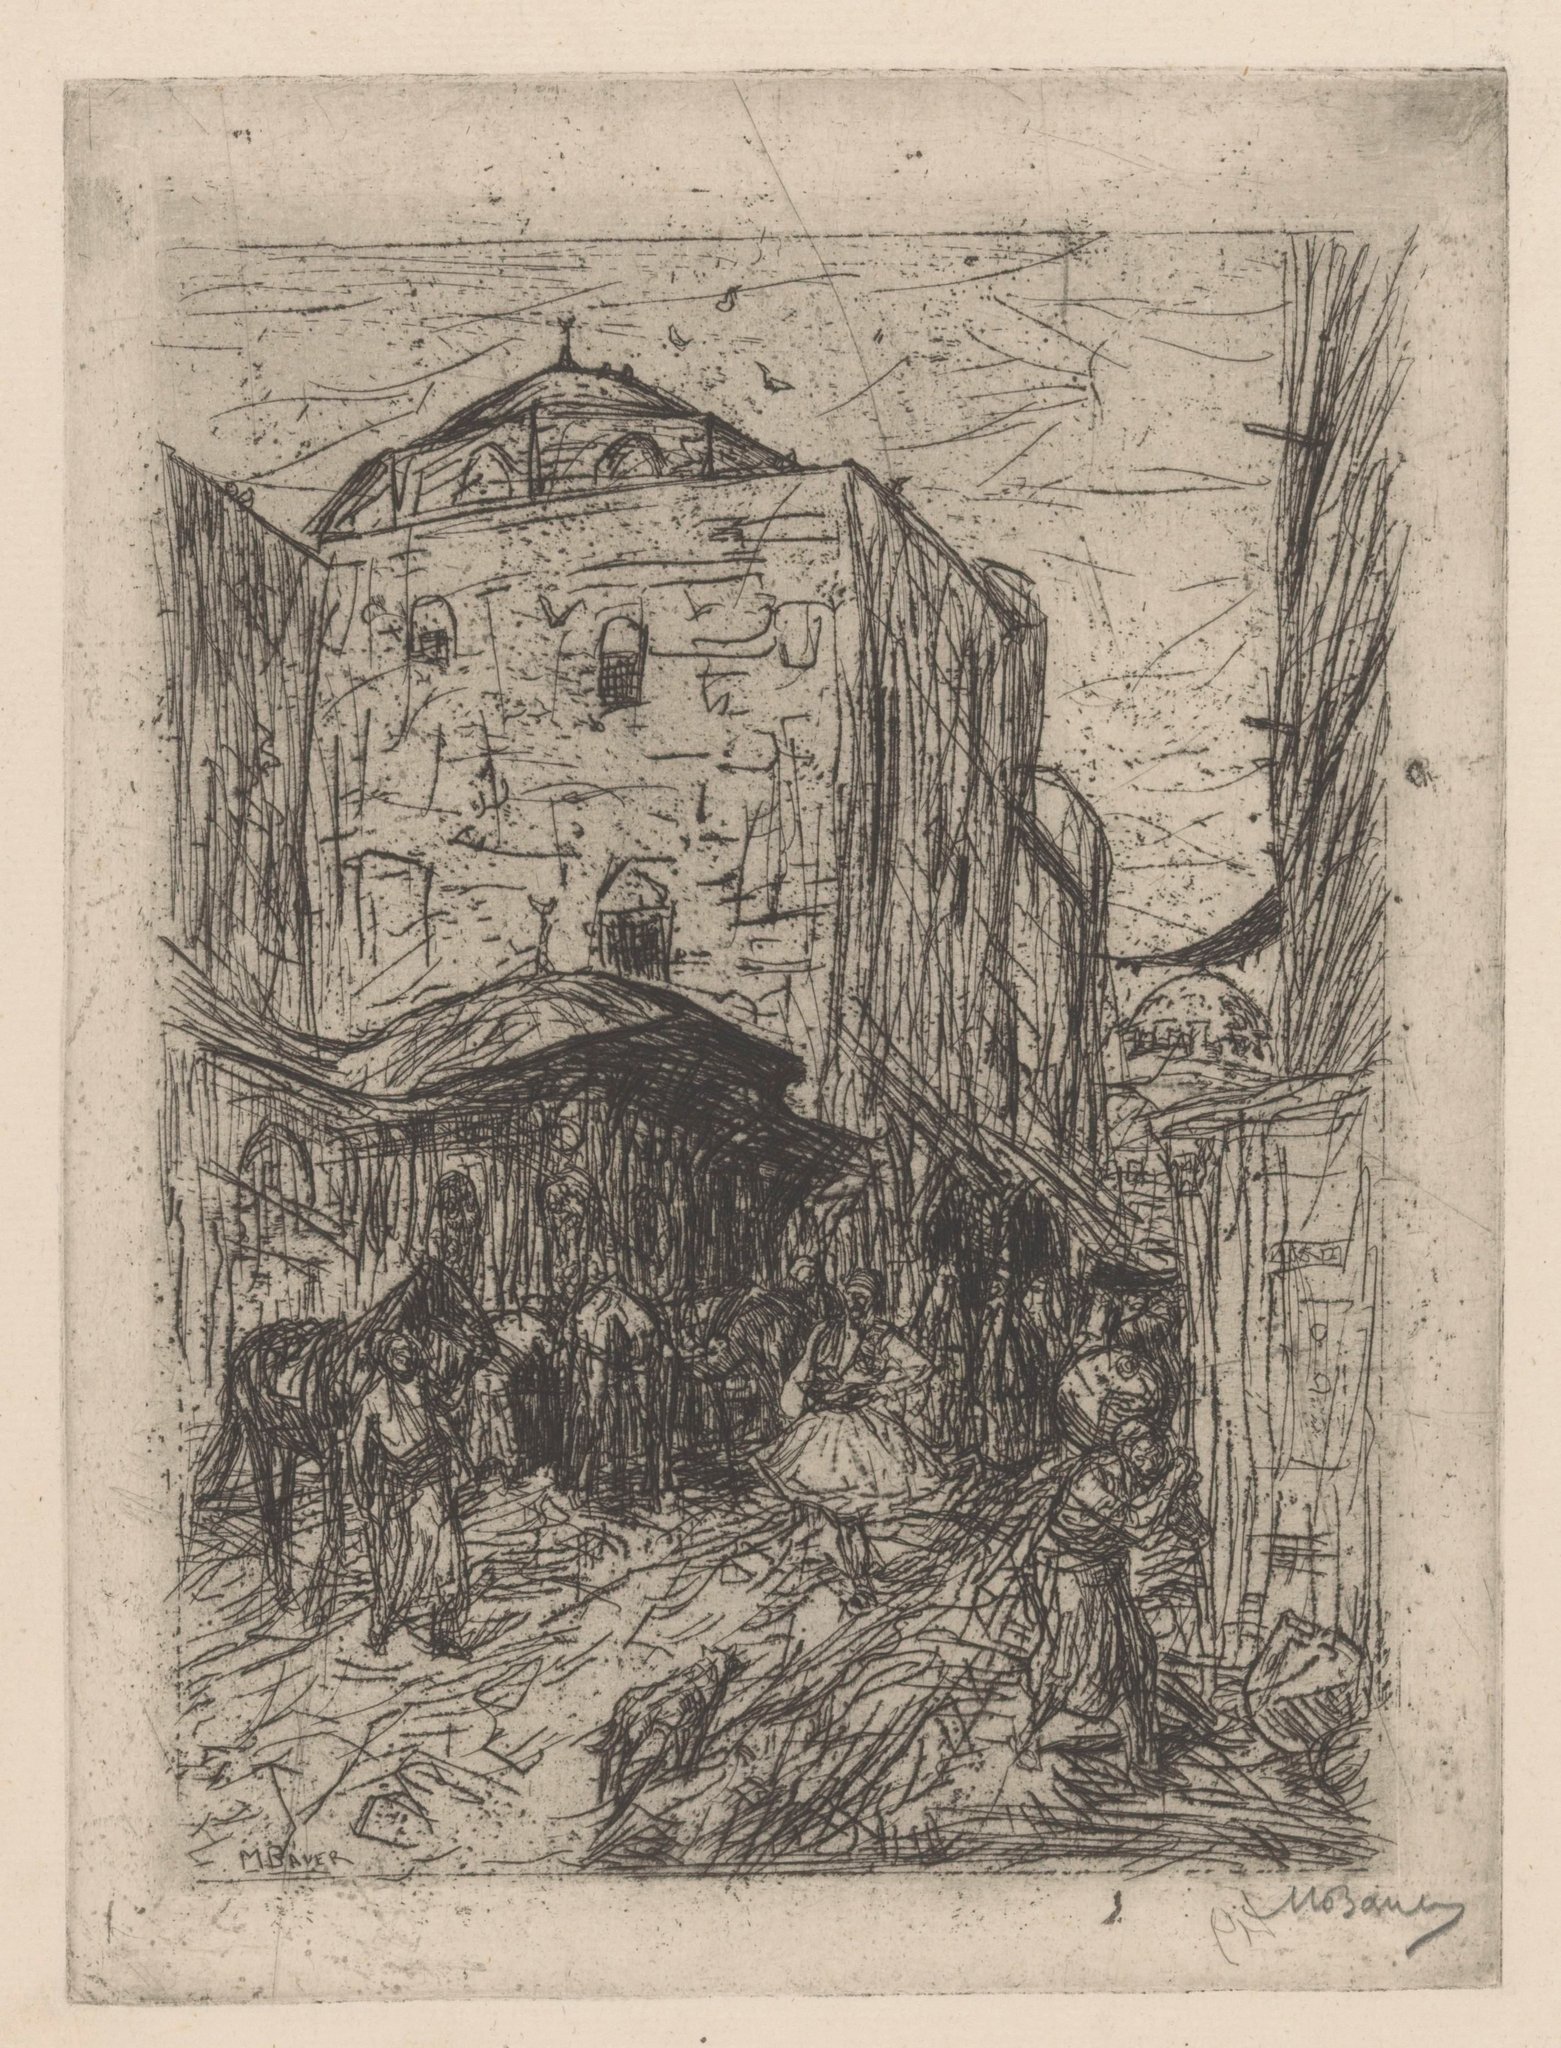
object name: print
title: Fontein in Constantinopel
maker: marius bauer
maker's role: draughtsman, print maker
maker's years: 1867-1932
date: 1890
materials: paper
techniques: intaglio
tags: ornamental fountain (in village), street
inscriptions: collector's mark: Lugt 2228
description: Een straat in Constantinopel met verschillende figuren, waaronder een man in Griekse klederdracht. Een groep figuren heeft zich met hun lastdieren rondom een fontein verzameld.